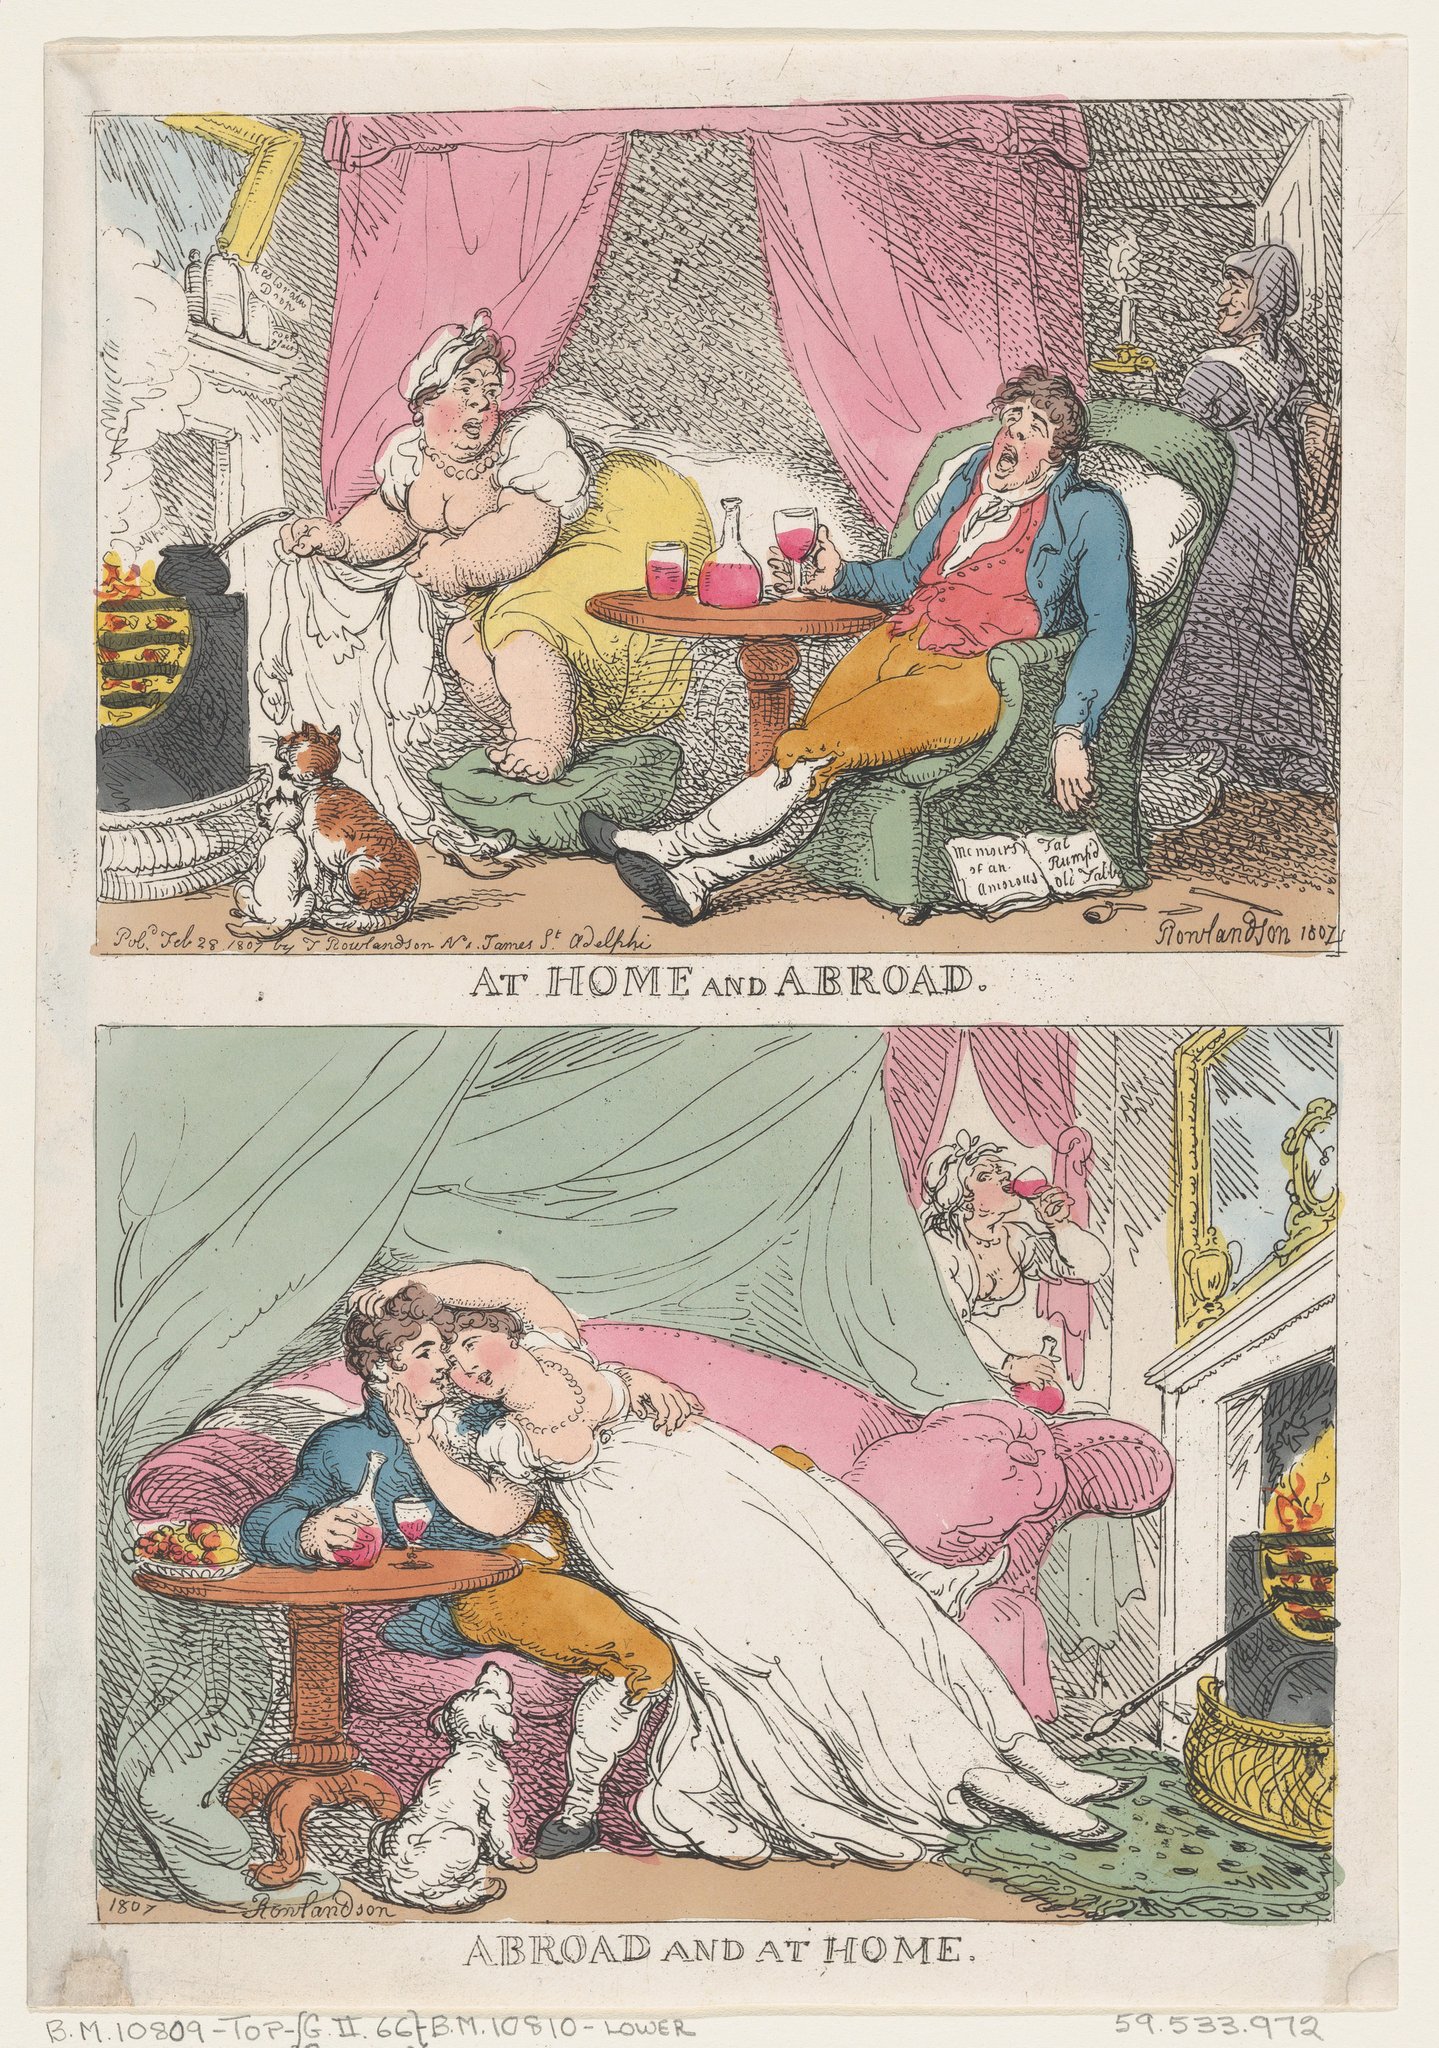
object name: print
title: At Home and Abroad, Abroad and At Home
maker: thomas rowlandson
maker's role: artist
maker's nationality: british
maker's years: 1757-1827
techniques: etching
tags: satire,couples,men,women,cats,dogs,drinking